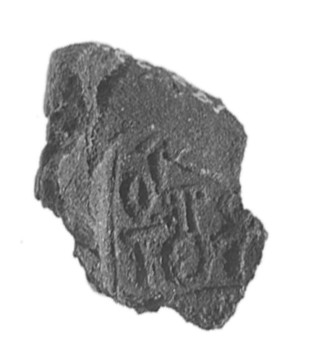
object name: sealing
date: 2030-1640 BCE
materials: clay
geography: egypt